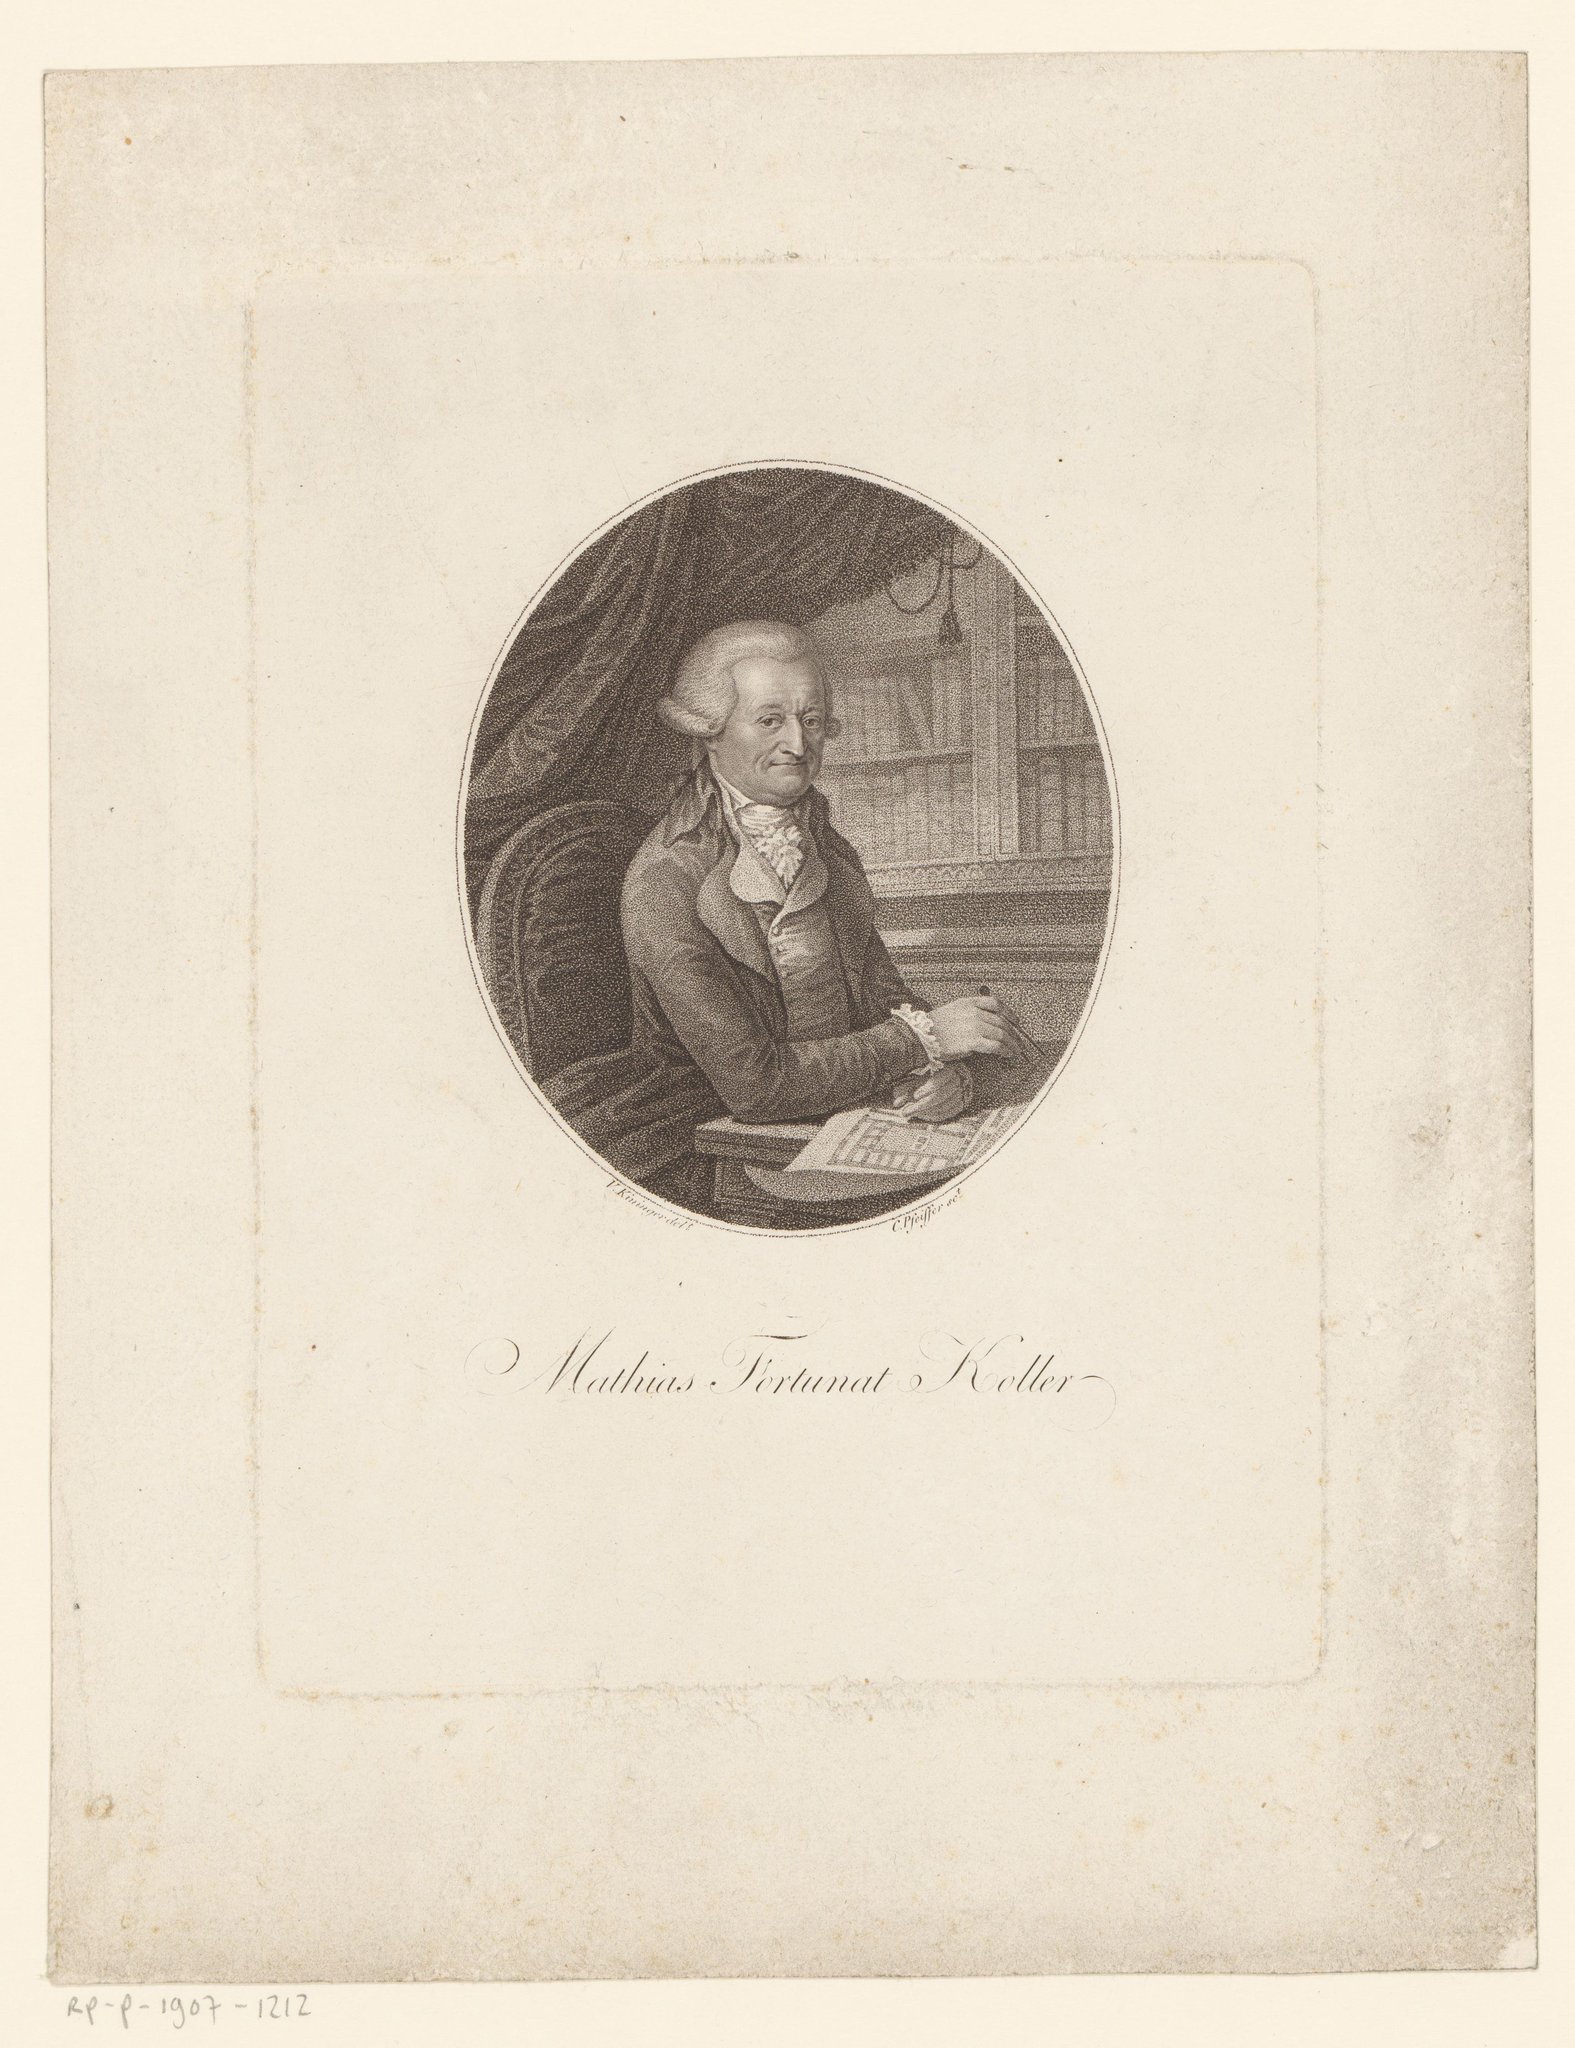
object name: print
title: Portret van Mathias Fortunat Koller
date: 1779-1829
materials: paper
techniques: stippled etching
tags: bookshelves, historical persons, plan ~ architecture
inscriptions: collector's mark: Lugt 2228